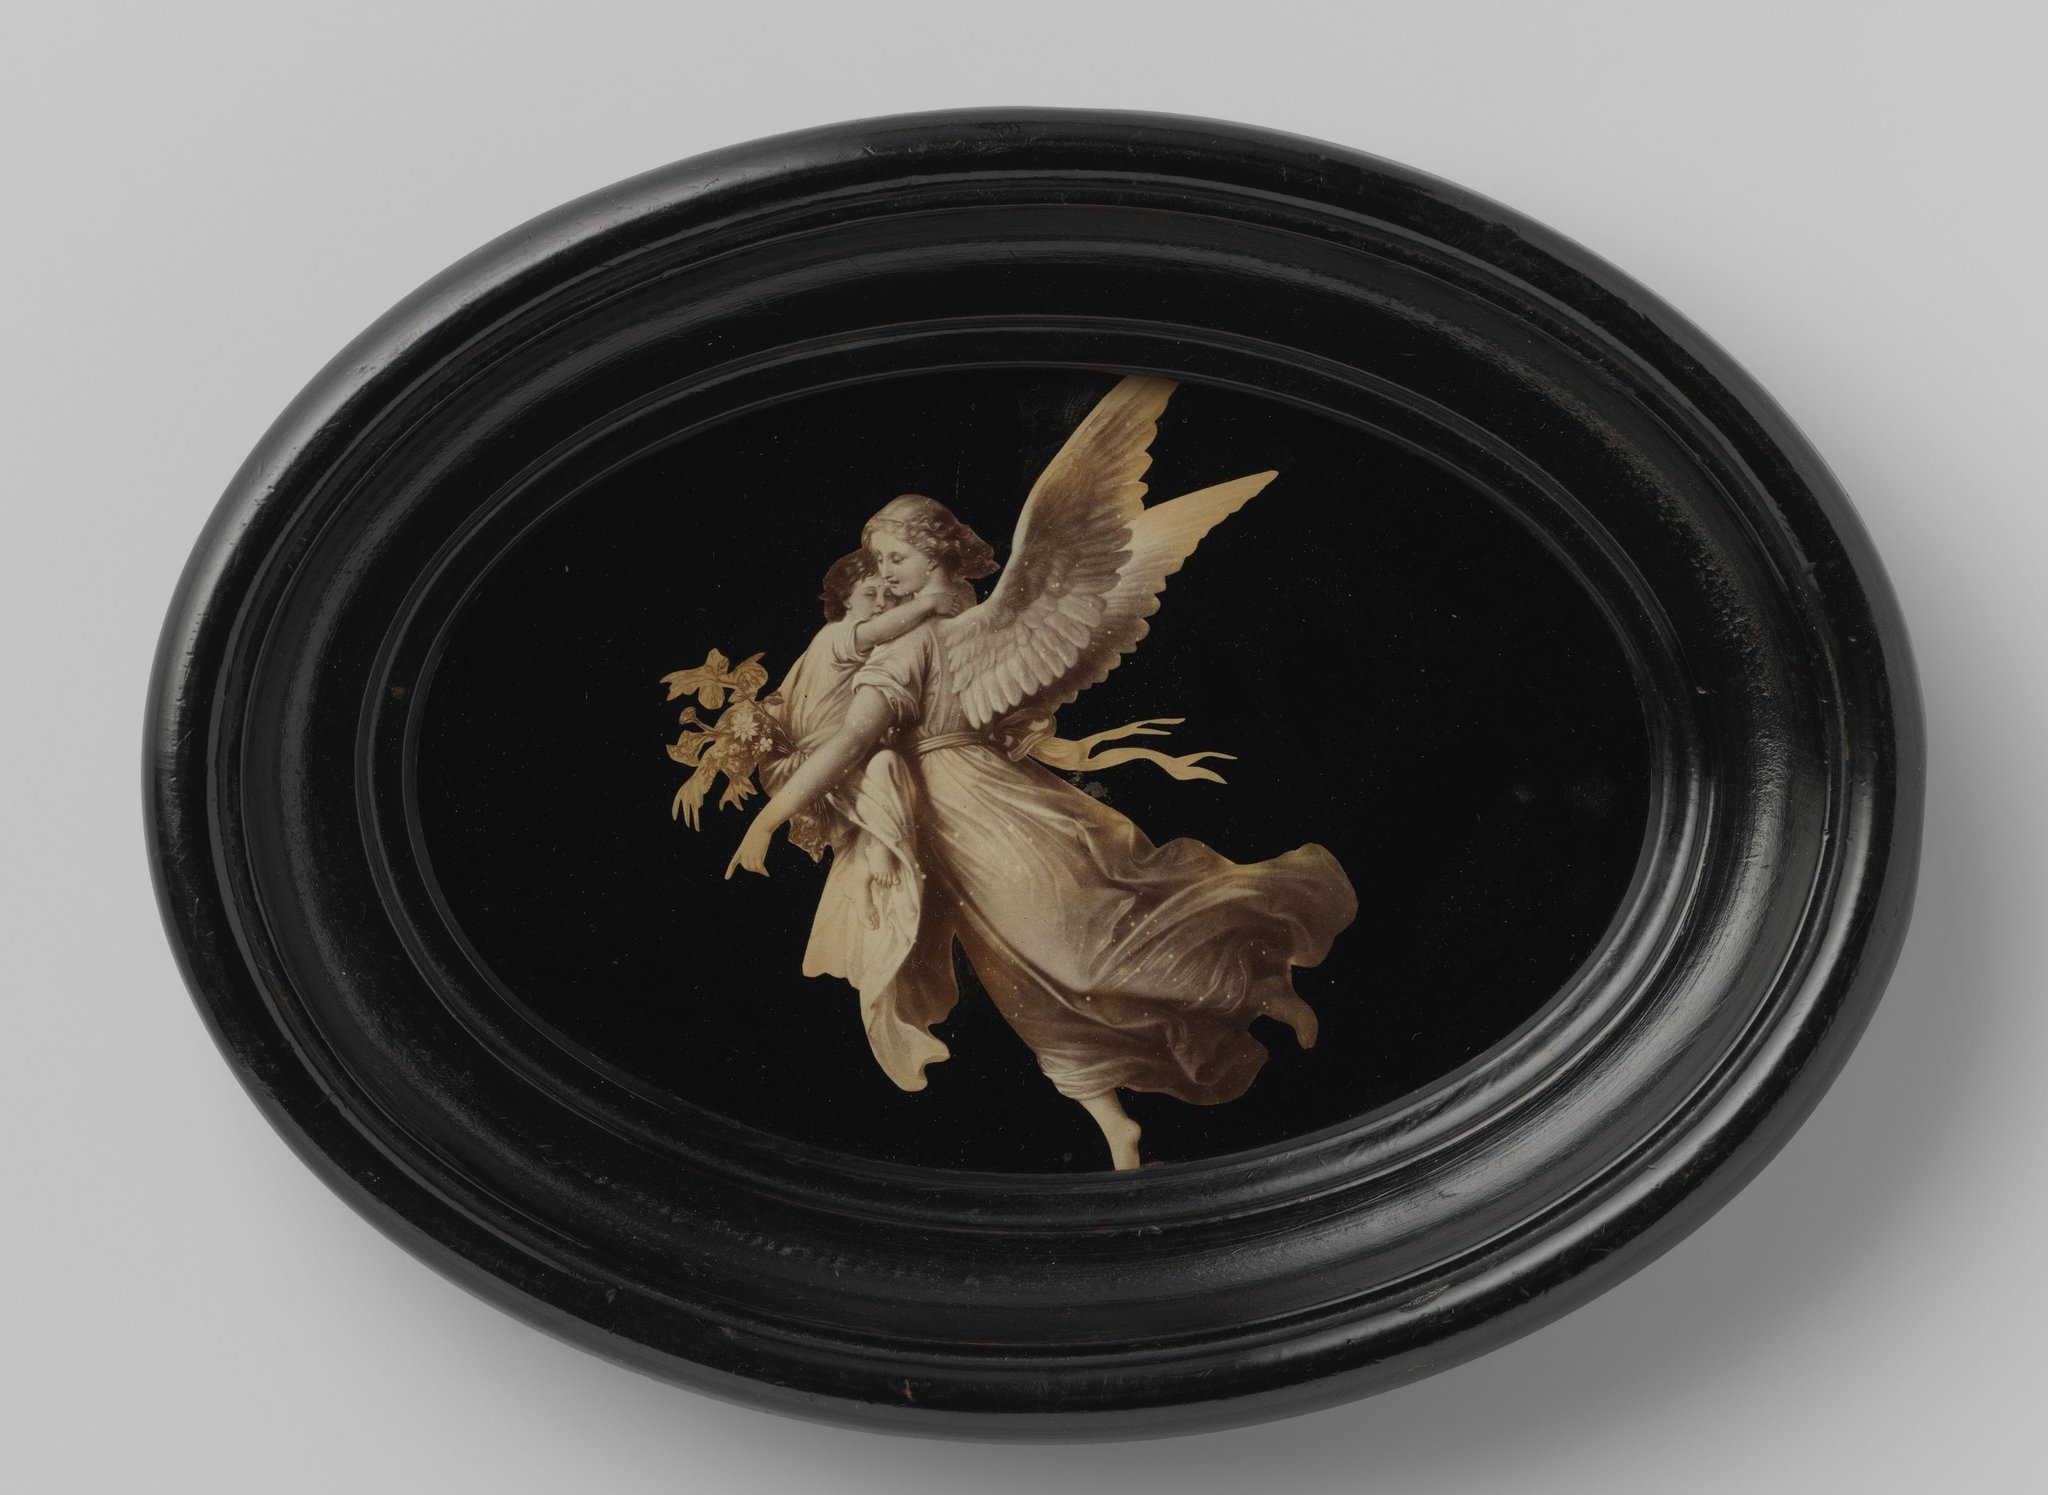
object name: frame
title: Sculptuur van een beschermengel met kind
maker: Anonymous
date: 1870-1910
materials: glass, lacquer, metal, paper, wood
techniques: albumen print, lacquer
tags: guardian angel, piece of sculpture, reproduction of a piece of sculpture